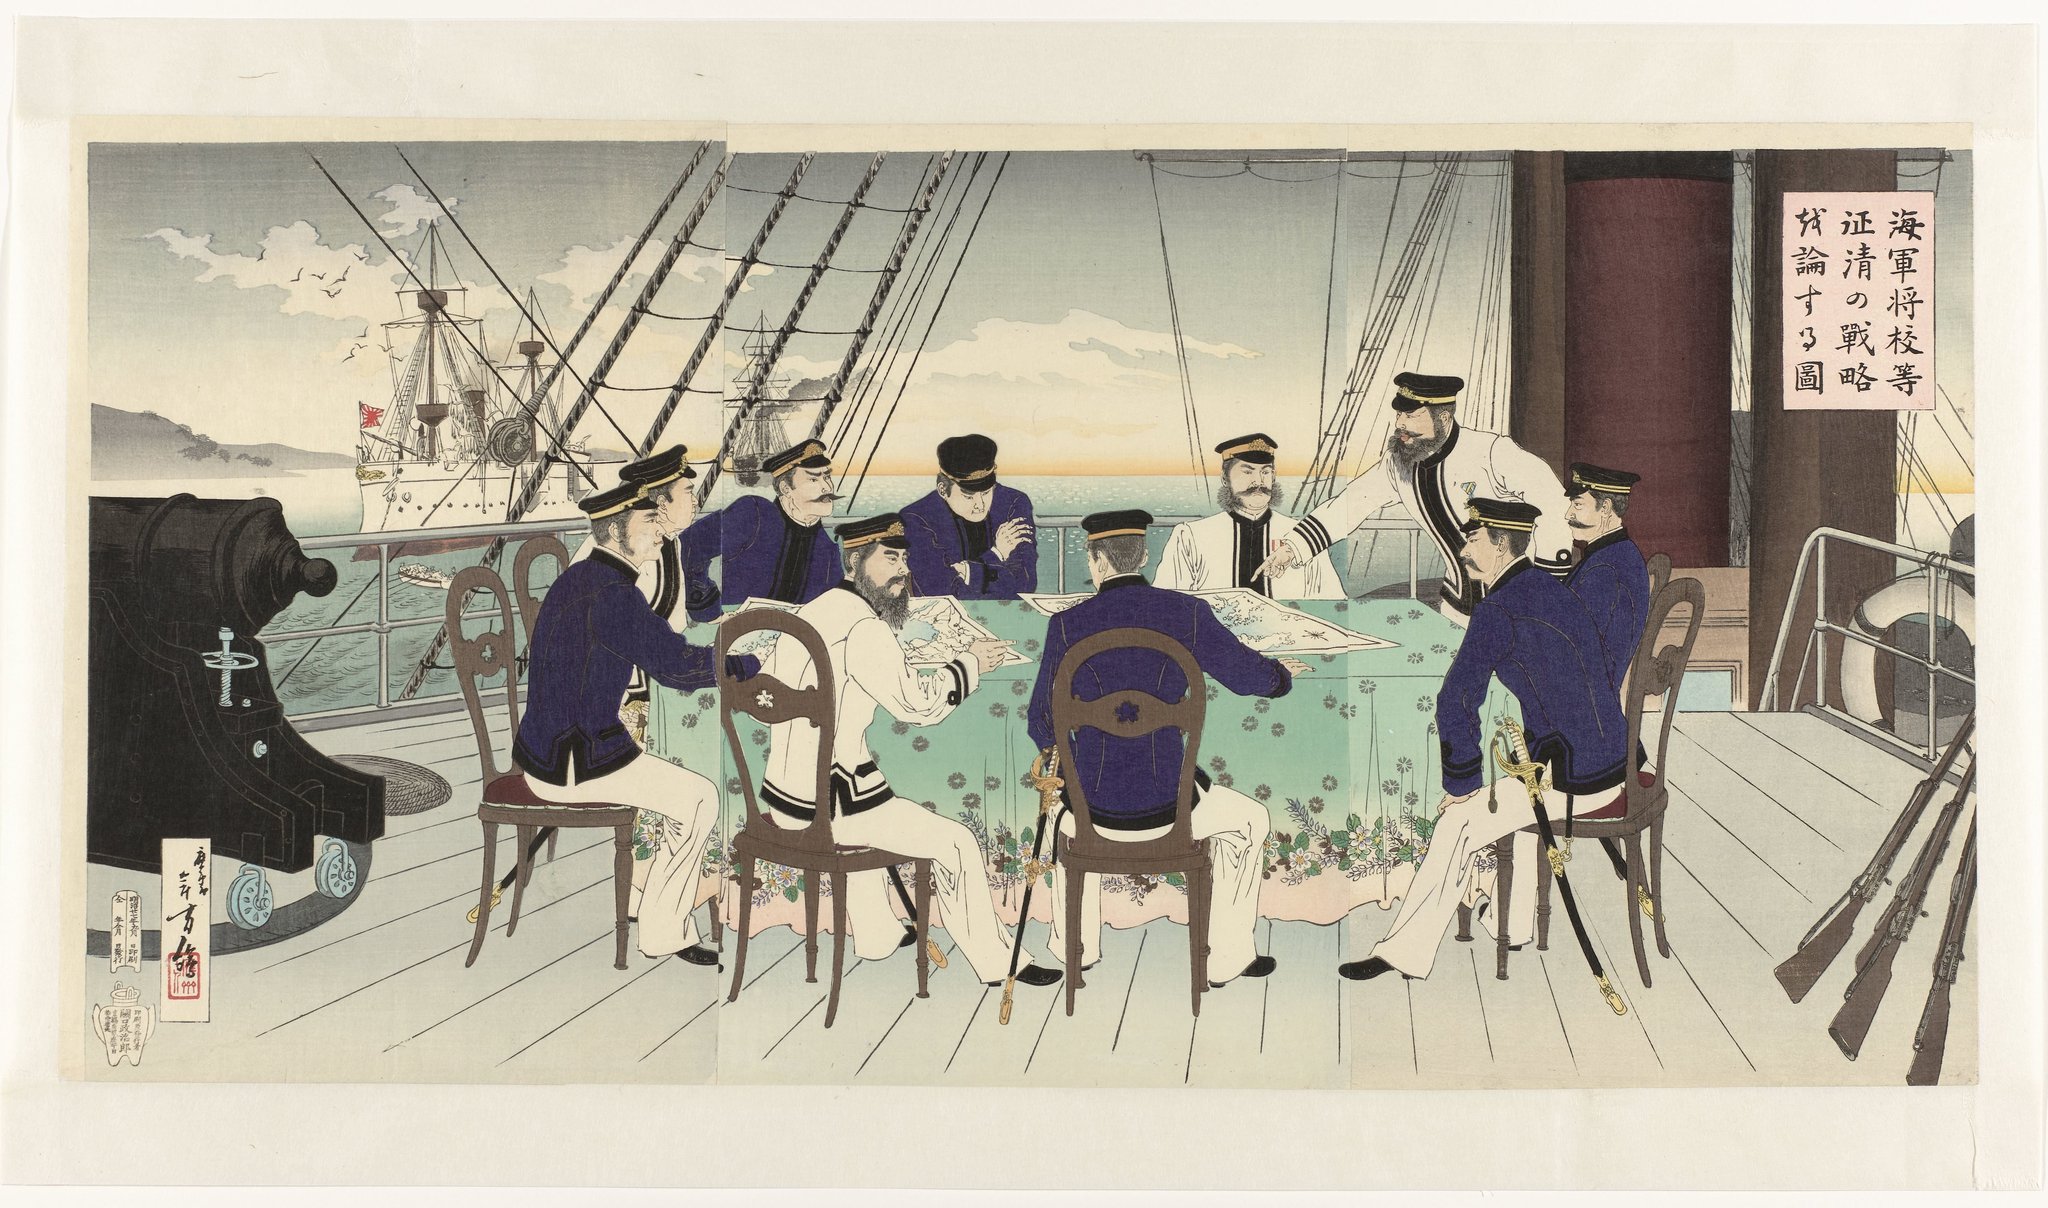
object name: print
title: Kaigun shôkôra seishin no senryuaku o ronzuru zu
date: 1894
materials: paper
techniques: woodcut, polish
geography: japan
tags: seaman, officer, plan of battle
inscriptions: label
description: Japanse marine officieren plannen hoe ze de Gele Zee kunnen veroveren. Deze zeeslag vond plaats in september 1894, tijdens de Eerste Chinees-Japanse Oorlog (1894-1895).